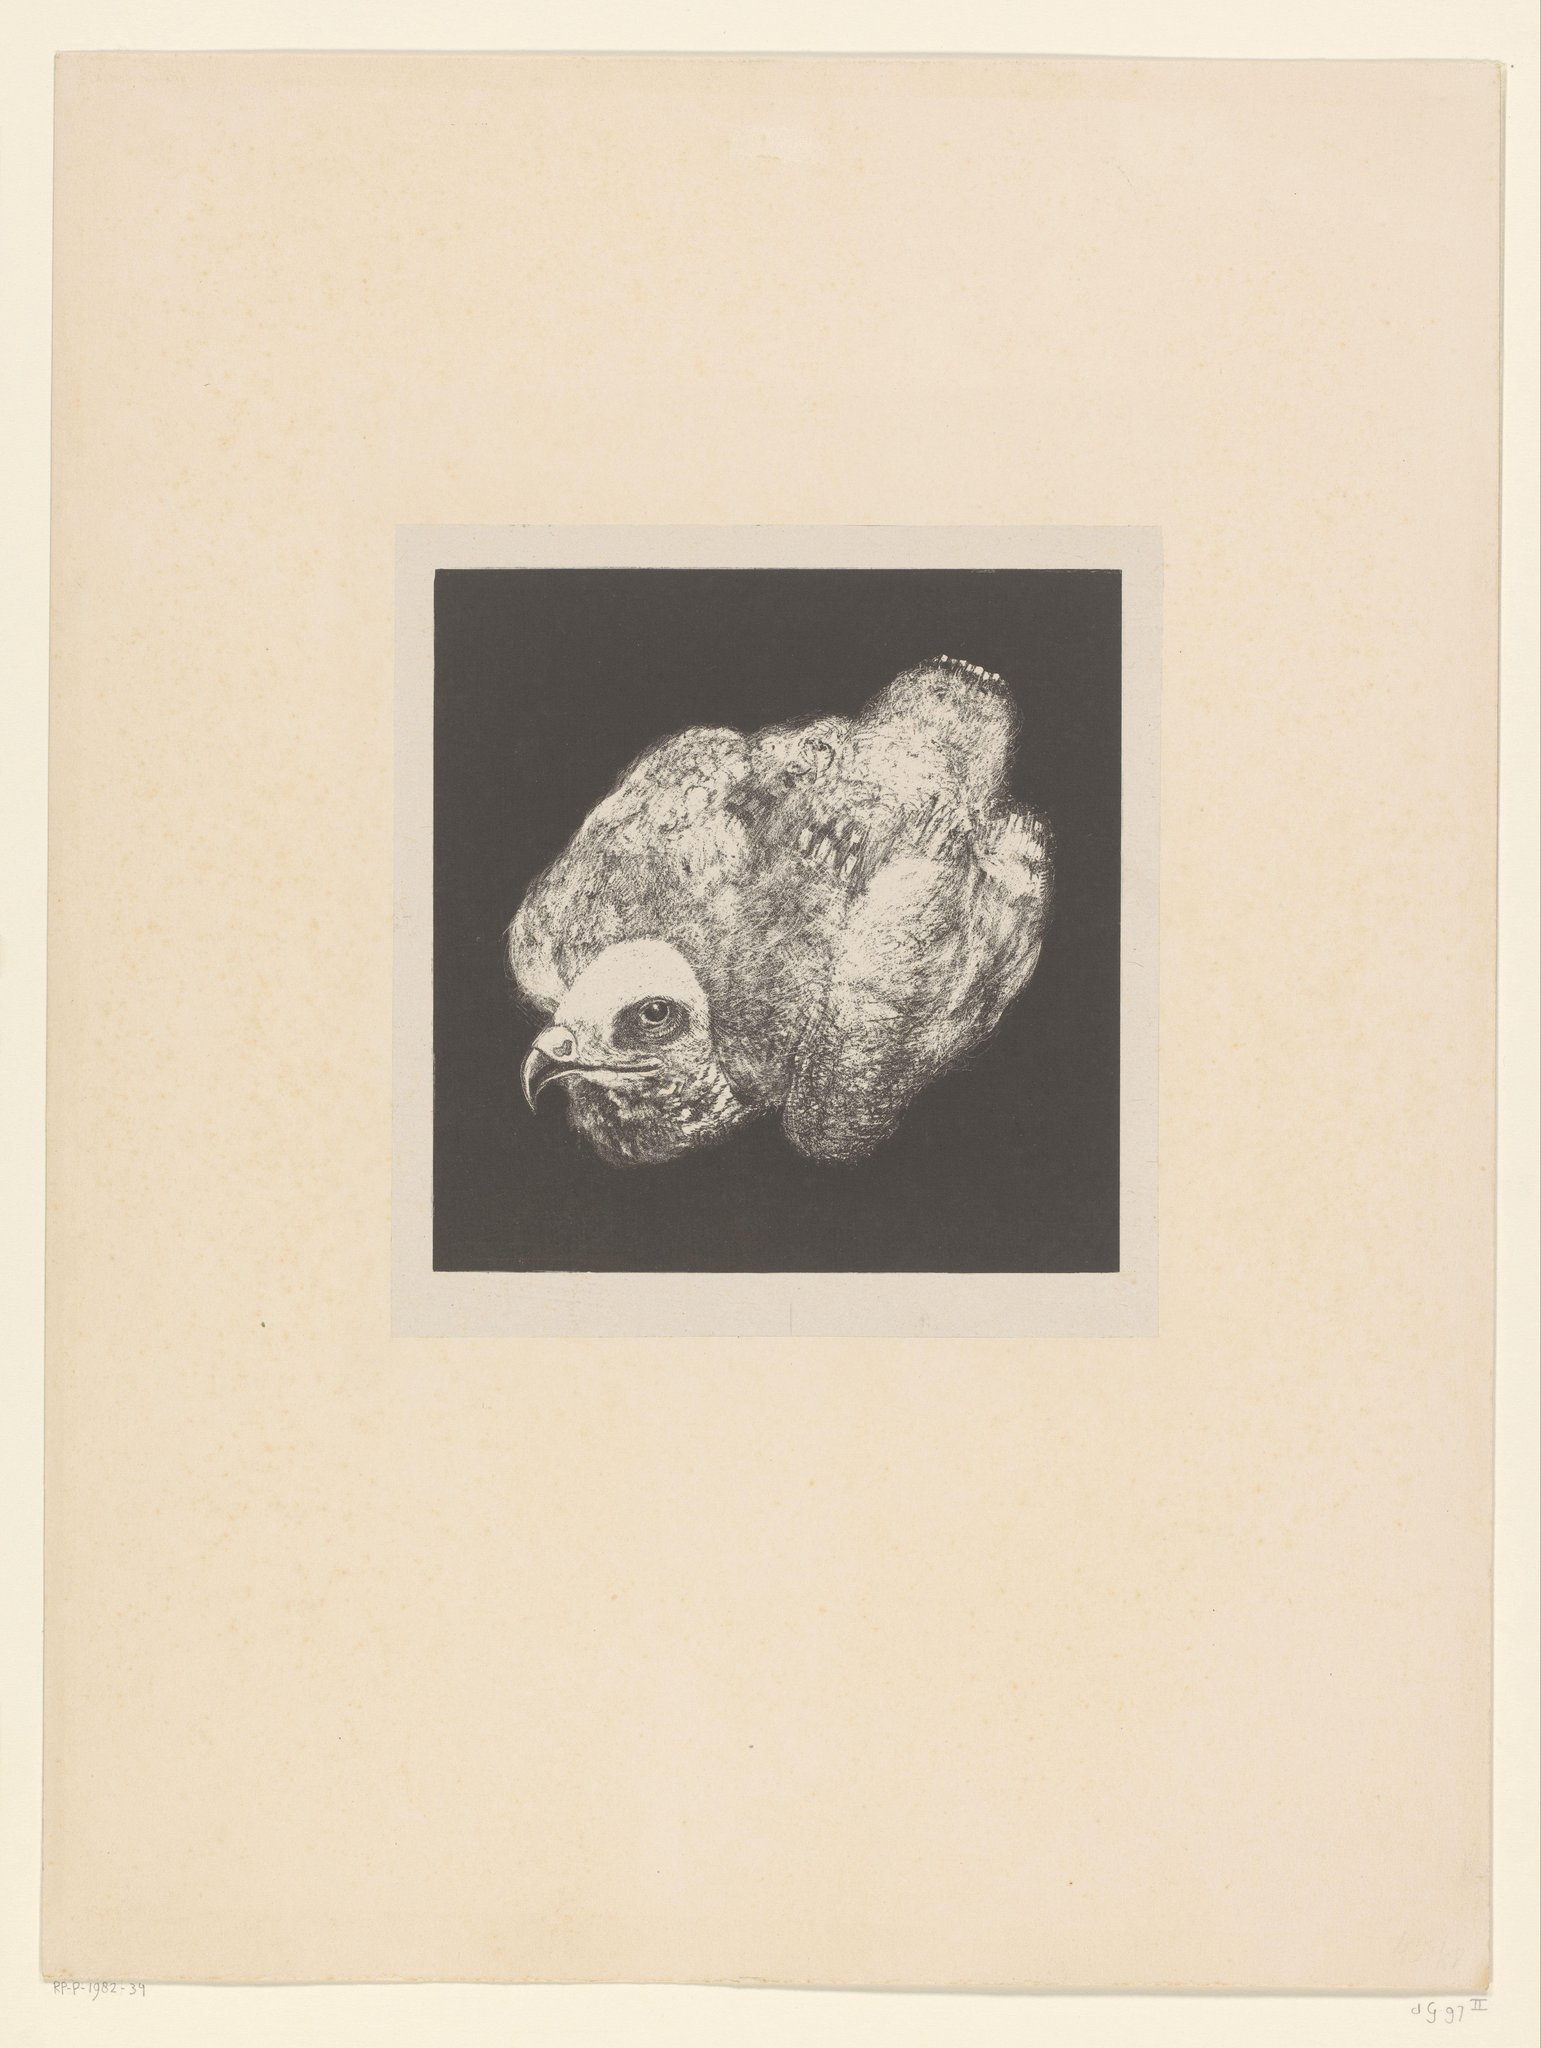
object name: print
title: Kiekendief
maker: theo van hoytema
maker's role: draughtsman, painter, print maker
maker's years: 1863-1917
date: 1878-1917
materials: paper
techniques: lithograph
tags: predatory birds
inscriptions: collector's mark: Lugt 2760, collector's mark: Lugt 2228